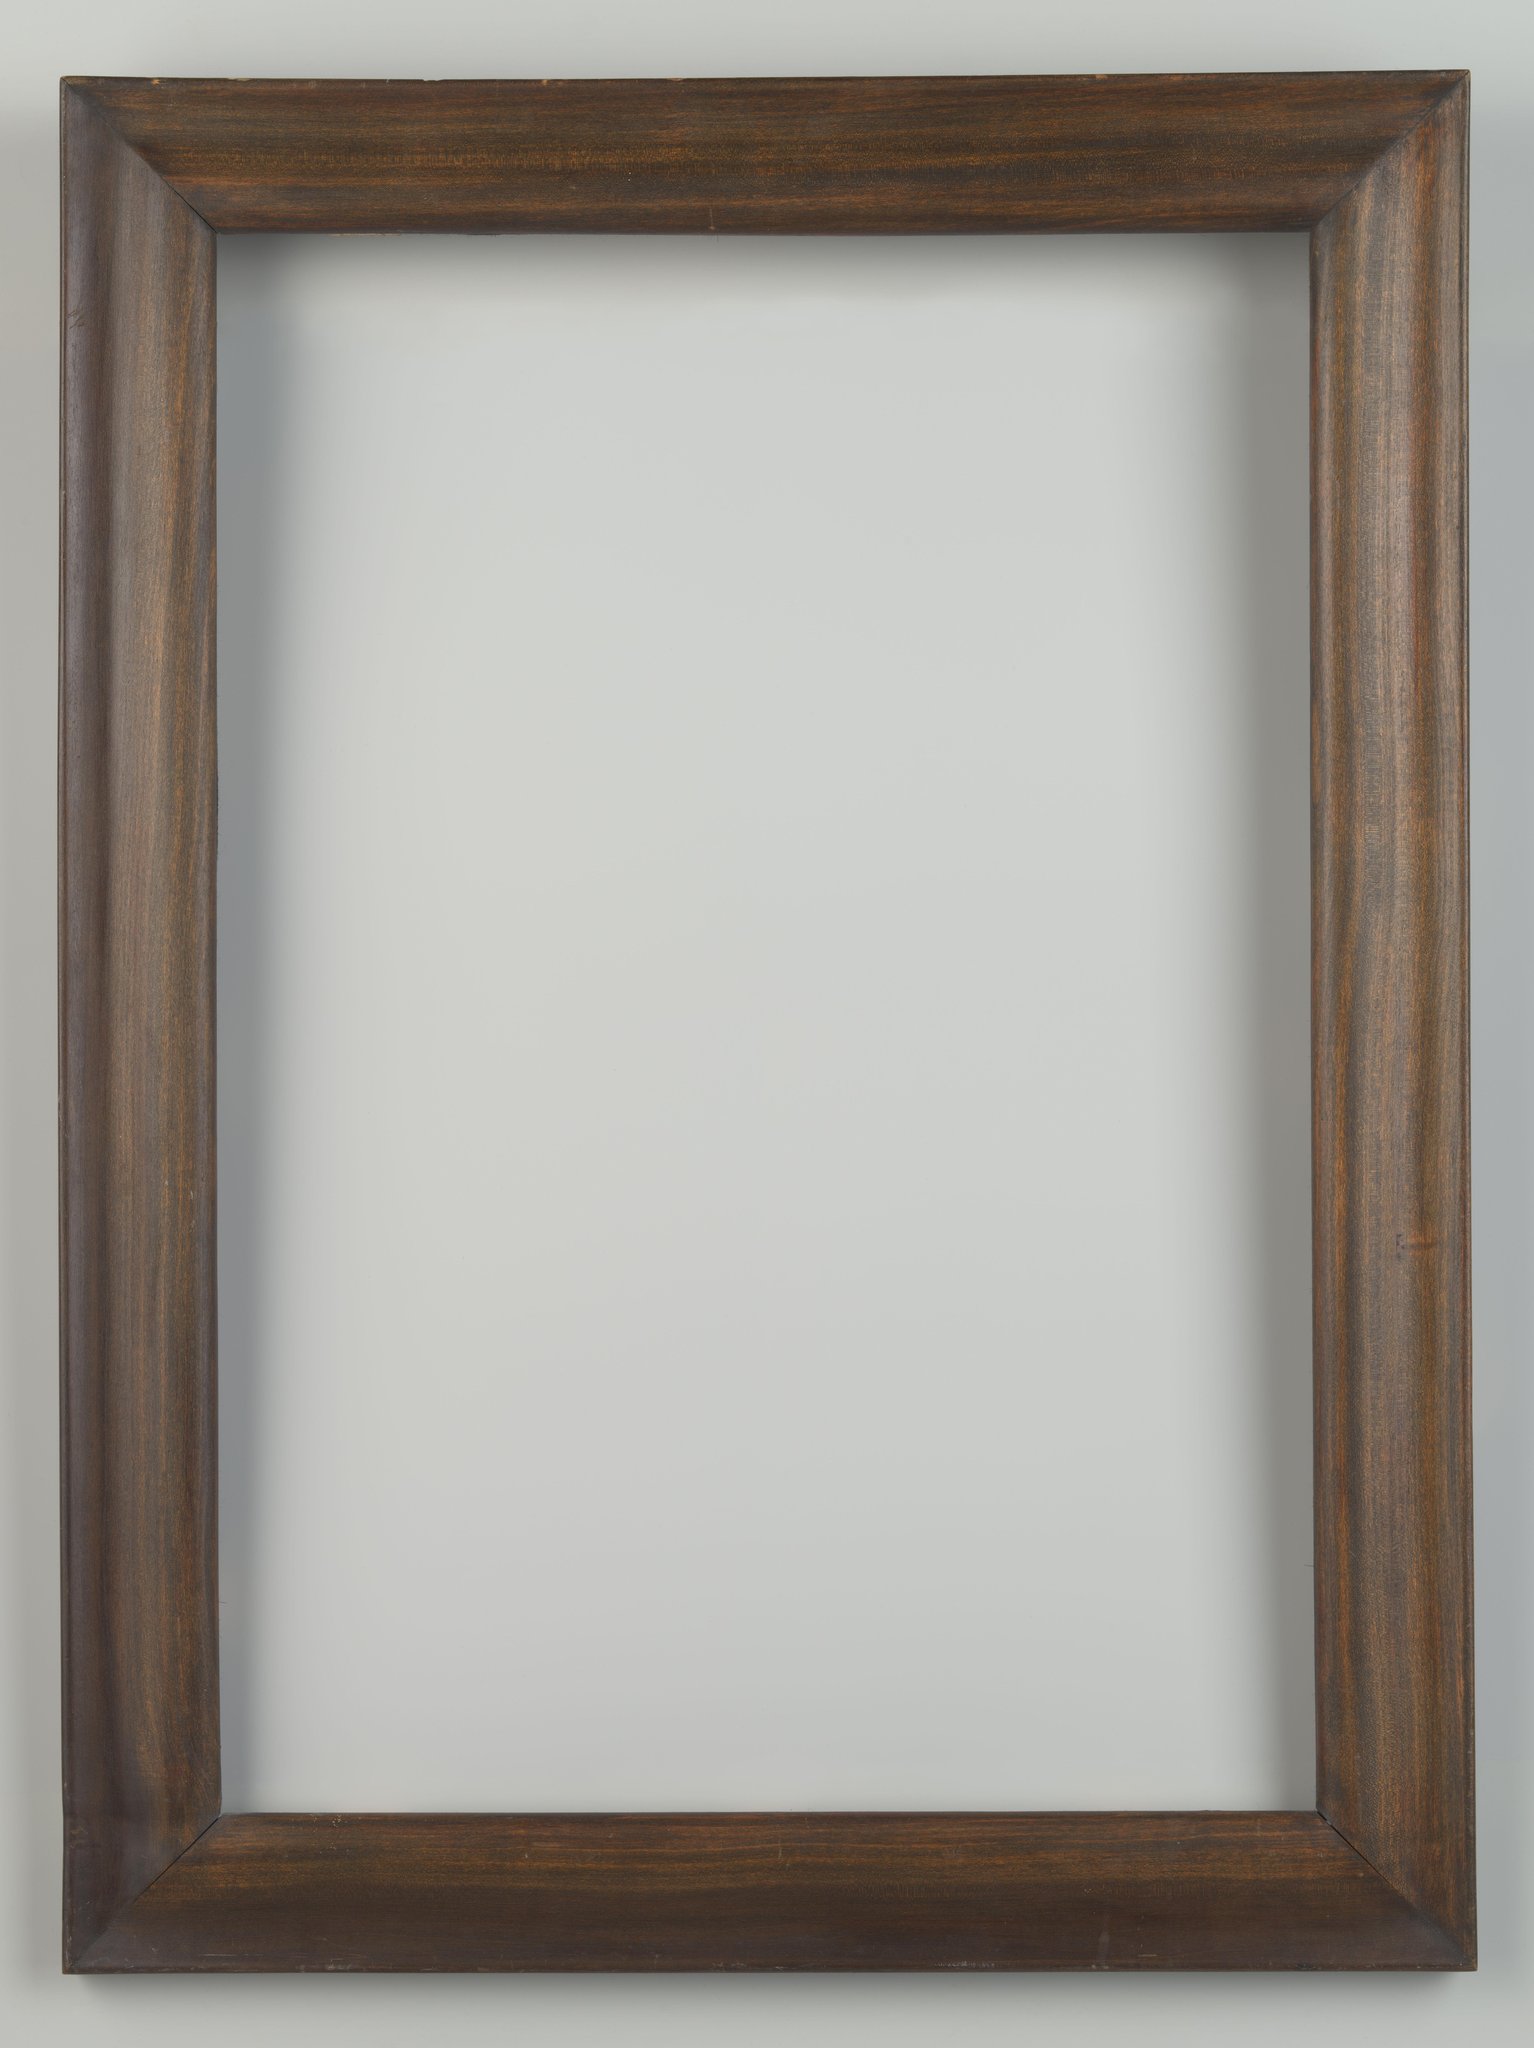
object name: frame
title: Bruin gebeitste mahoniehouten lijst met ojiefvorming profiel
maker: Anonymous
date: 1933-1999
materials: wood, wax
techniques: staining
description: Bruin gebeitste mahoniehouten profiellijst met ojiefvorming profiel. De lijst is afgewerkt met was. De hoekverbindingen zijn koud verstekt en gelijmd.